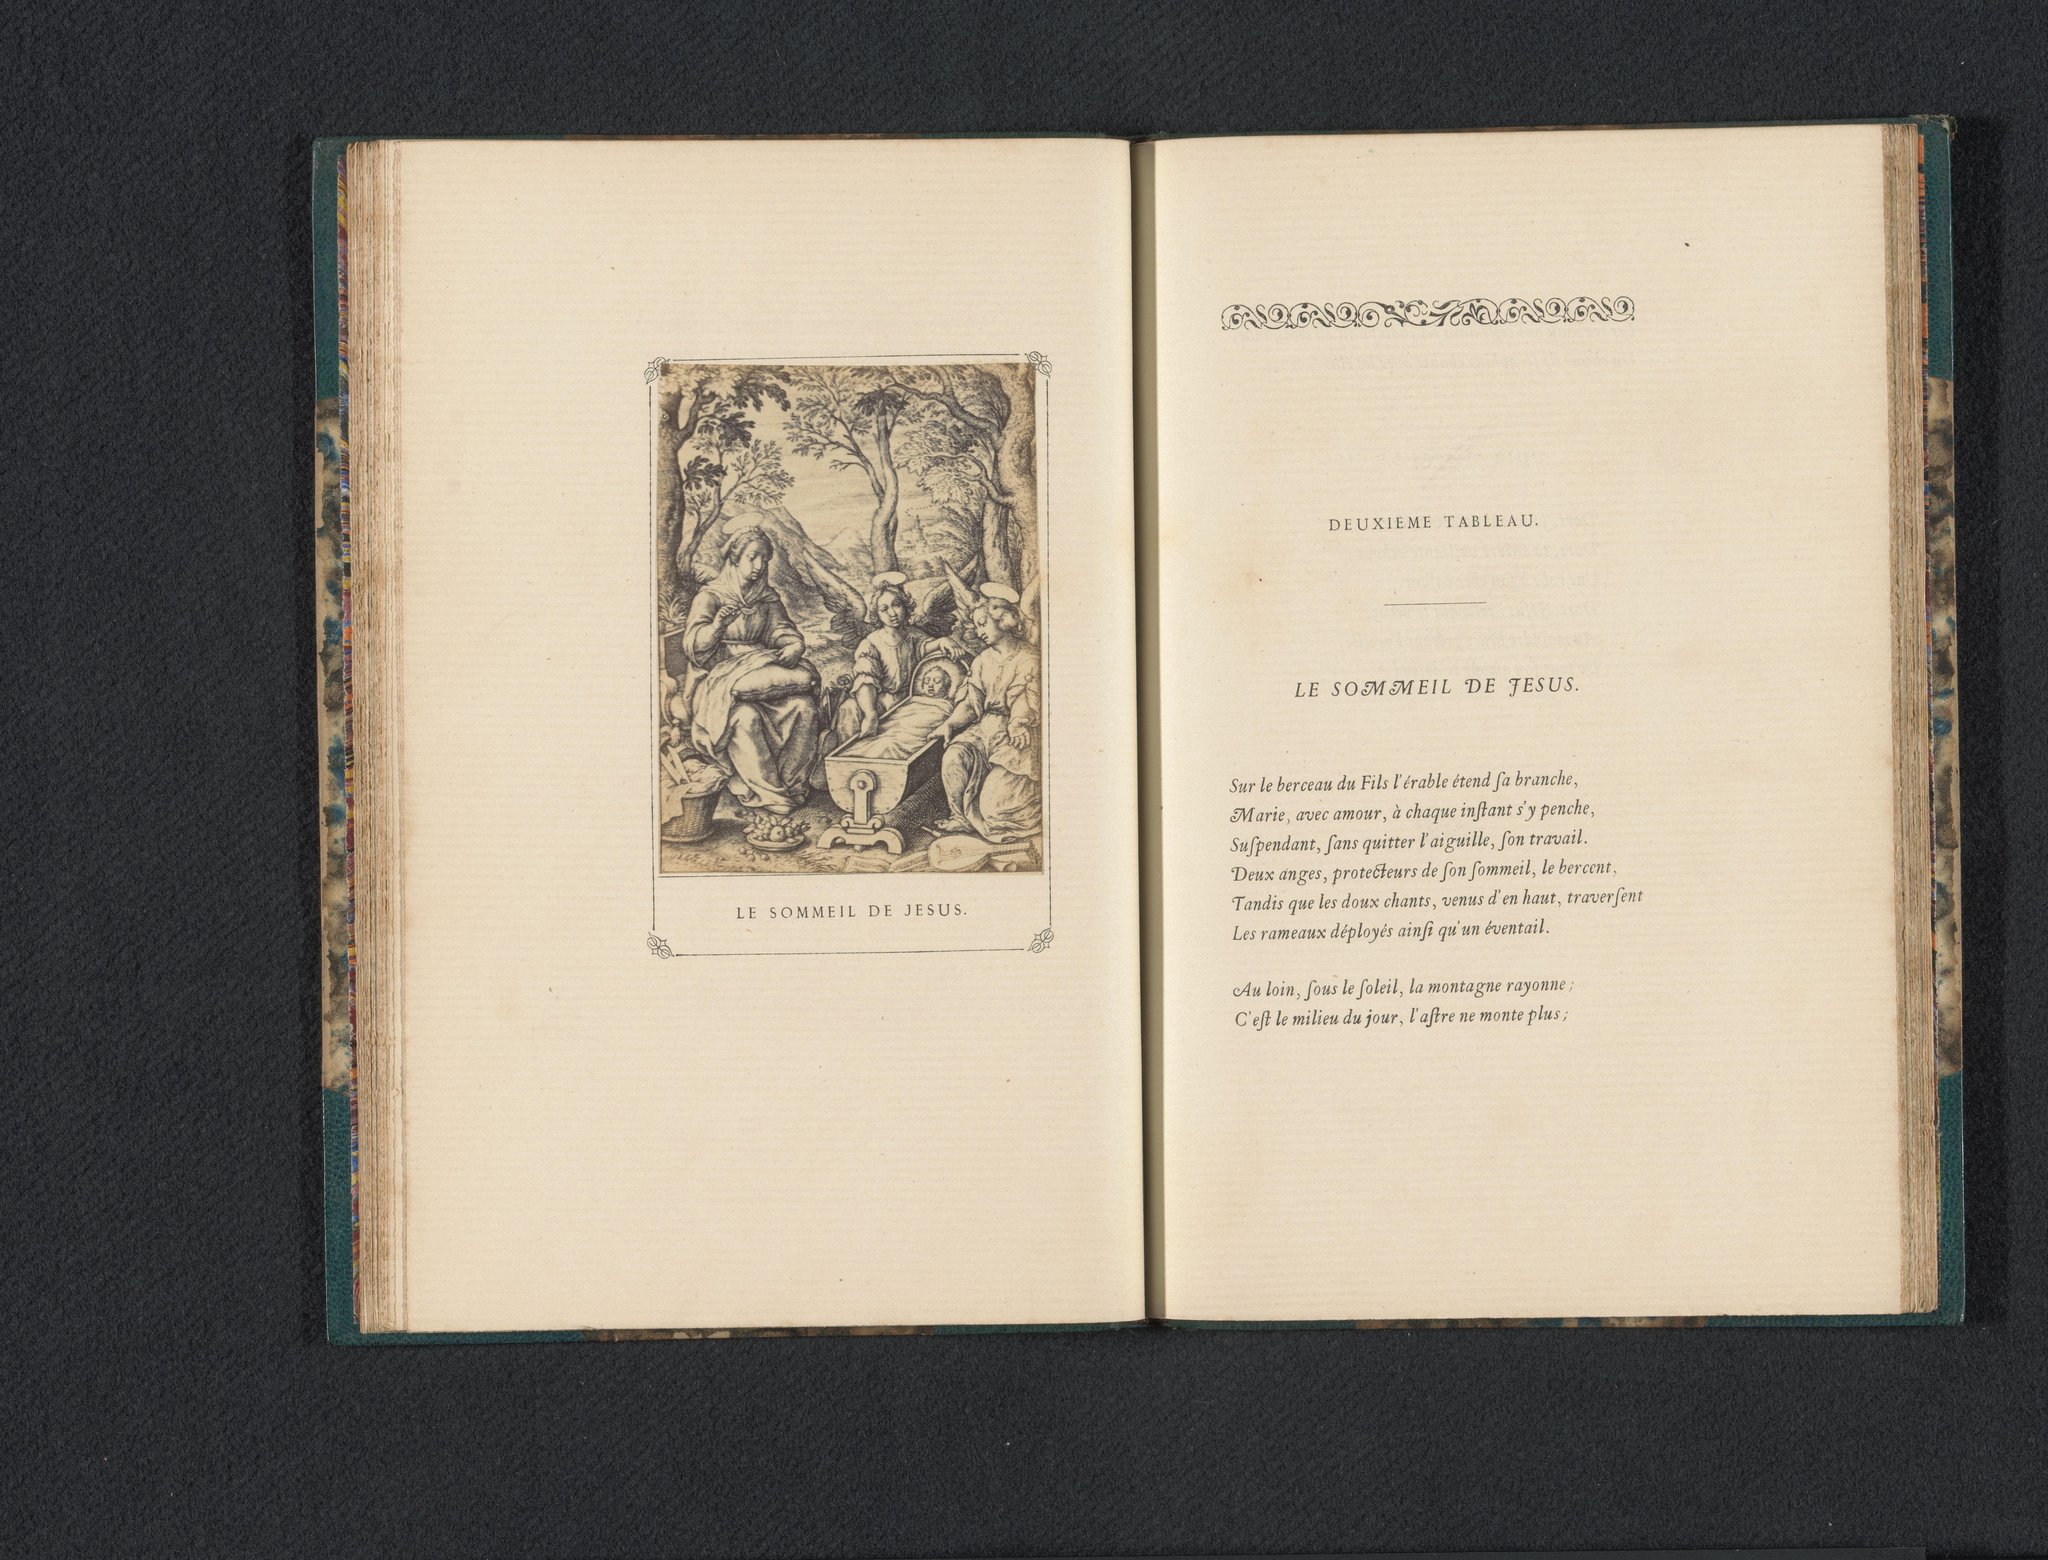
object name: page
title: Le sommeil de Jesus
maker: edmond fierlants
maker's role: fotograaf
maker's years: 1819-1869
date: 1855-1860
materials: photographic support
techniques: albumen print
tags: christ-child sleeping ~ madonna-representations (+ angel(s))